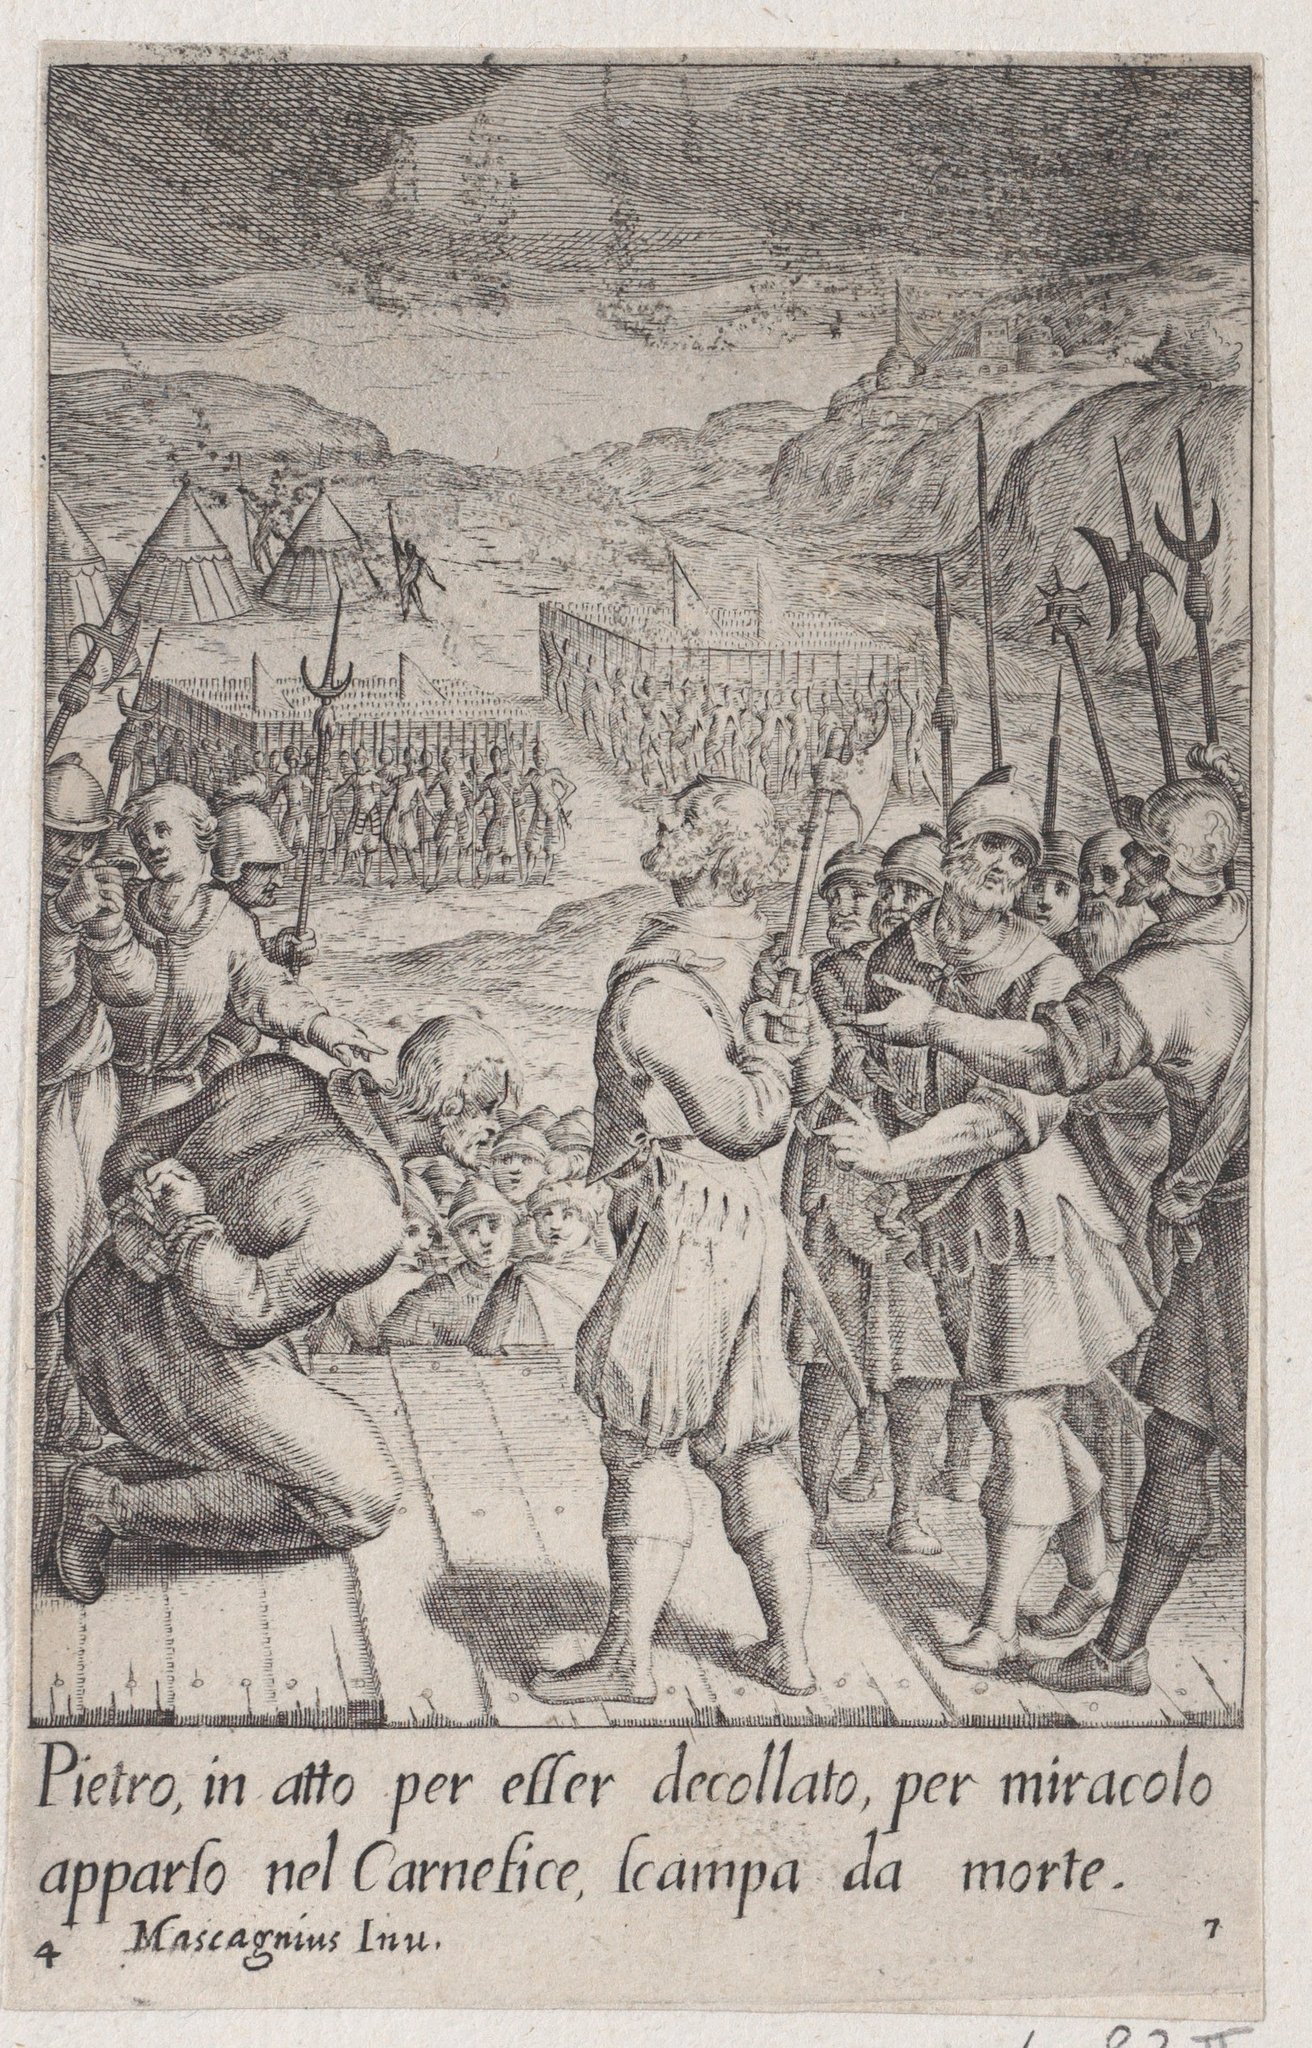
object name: print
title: The Executioner, from Scelta d'Alcuni Miracoli e Grazie della Santissima Nunziata di Firenze (Selection of Some Miracles and Graces that Occurred in the Church of the Annunziata in Florence)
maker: jacques callot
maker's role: artist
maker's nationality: french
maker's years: 1592-1635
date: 1611-1619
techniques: engraving